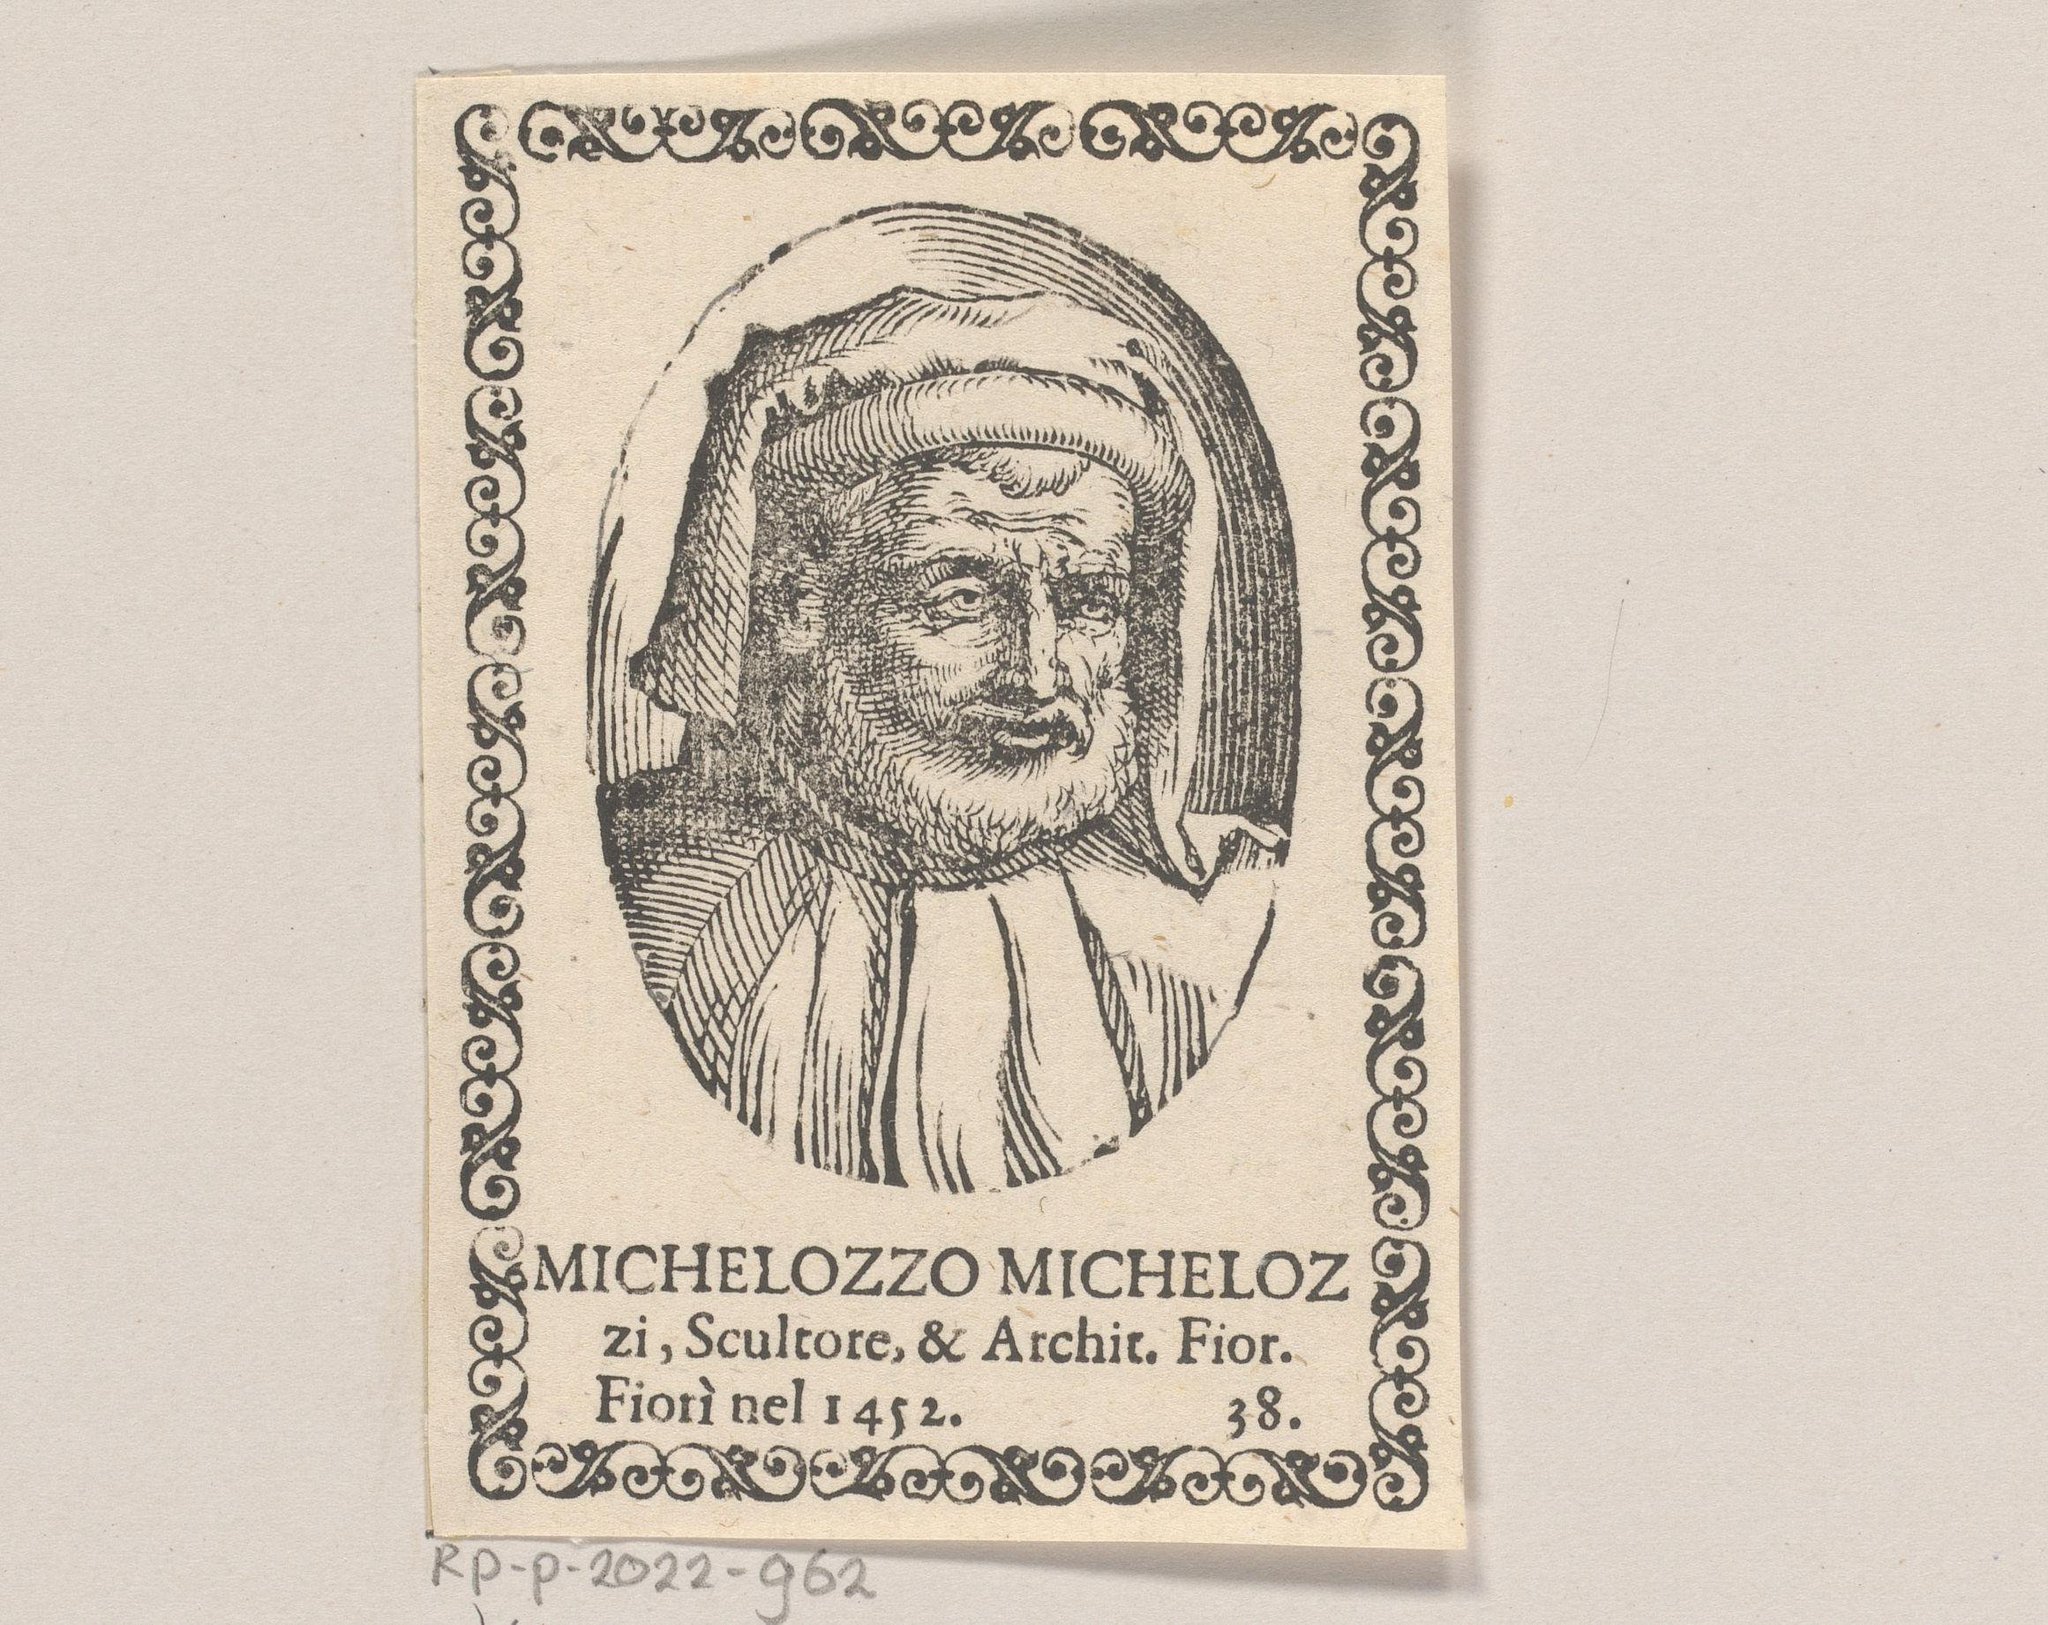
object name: book illustration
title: Portret van Michelozzo di Bartolomeo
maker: Anonymous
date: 1568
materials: paper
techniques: letterpress printing, engraving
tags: sculptor, michelozzo di bartolomeo, historical persons, portrait, self-portrait of artist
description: Prent waarschijnlijk uit: Vasari, Giorgio. Le Vite de' più eccellenti pittori, scultori, e architettori da Cimabue insino a' tempi nostri. Florence: Giunti, 1568.